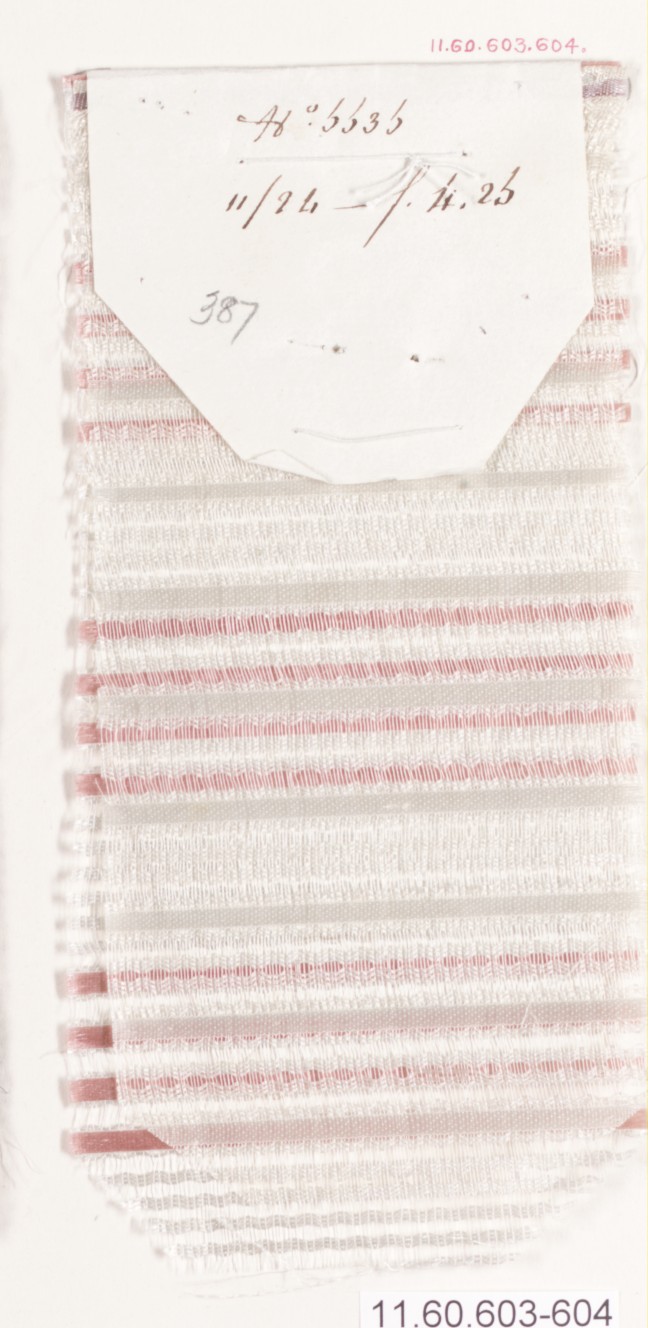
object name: sample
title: Samples (2)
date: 1801-1833